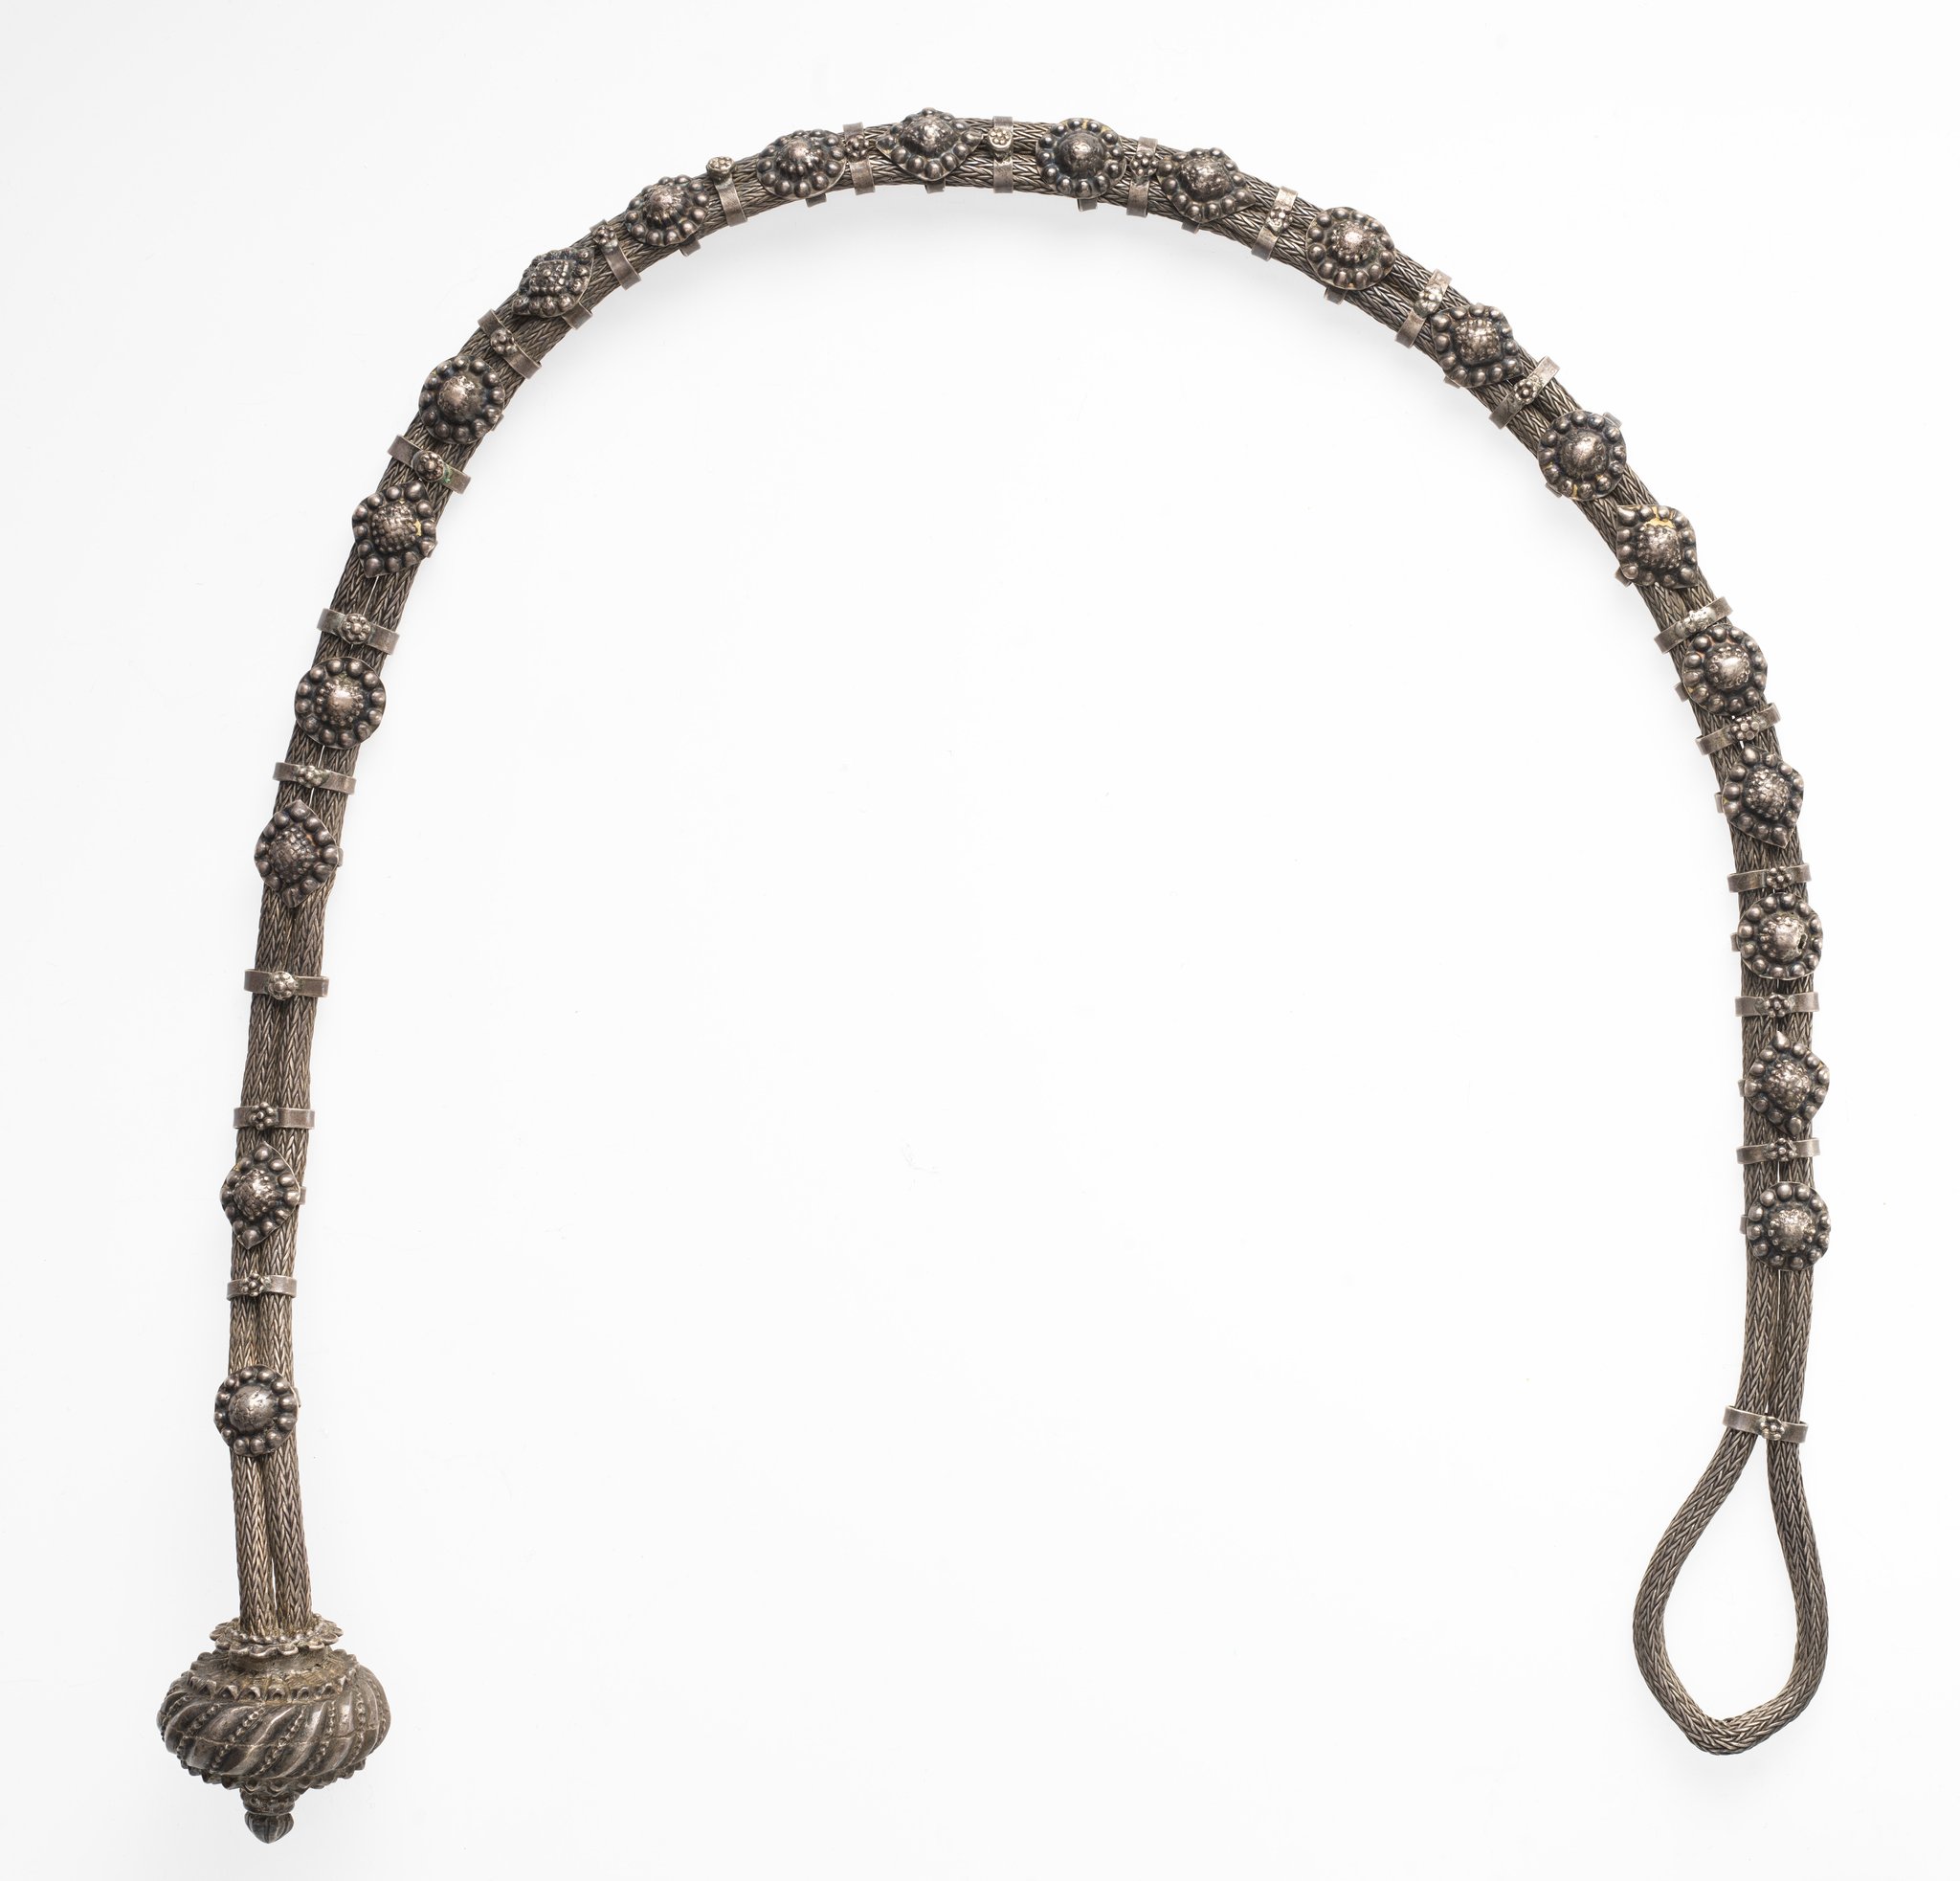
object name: horse trapping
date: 1701-1900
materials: silver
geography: india